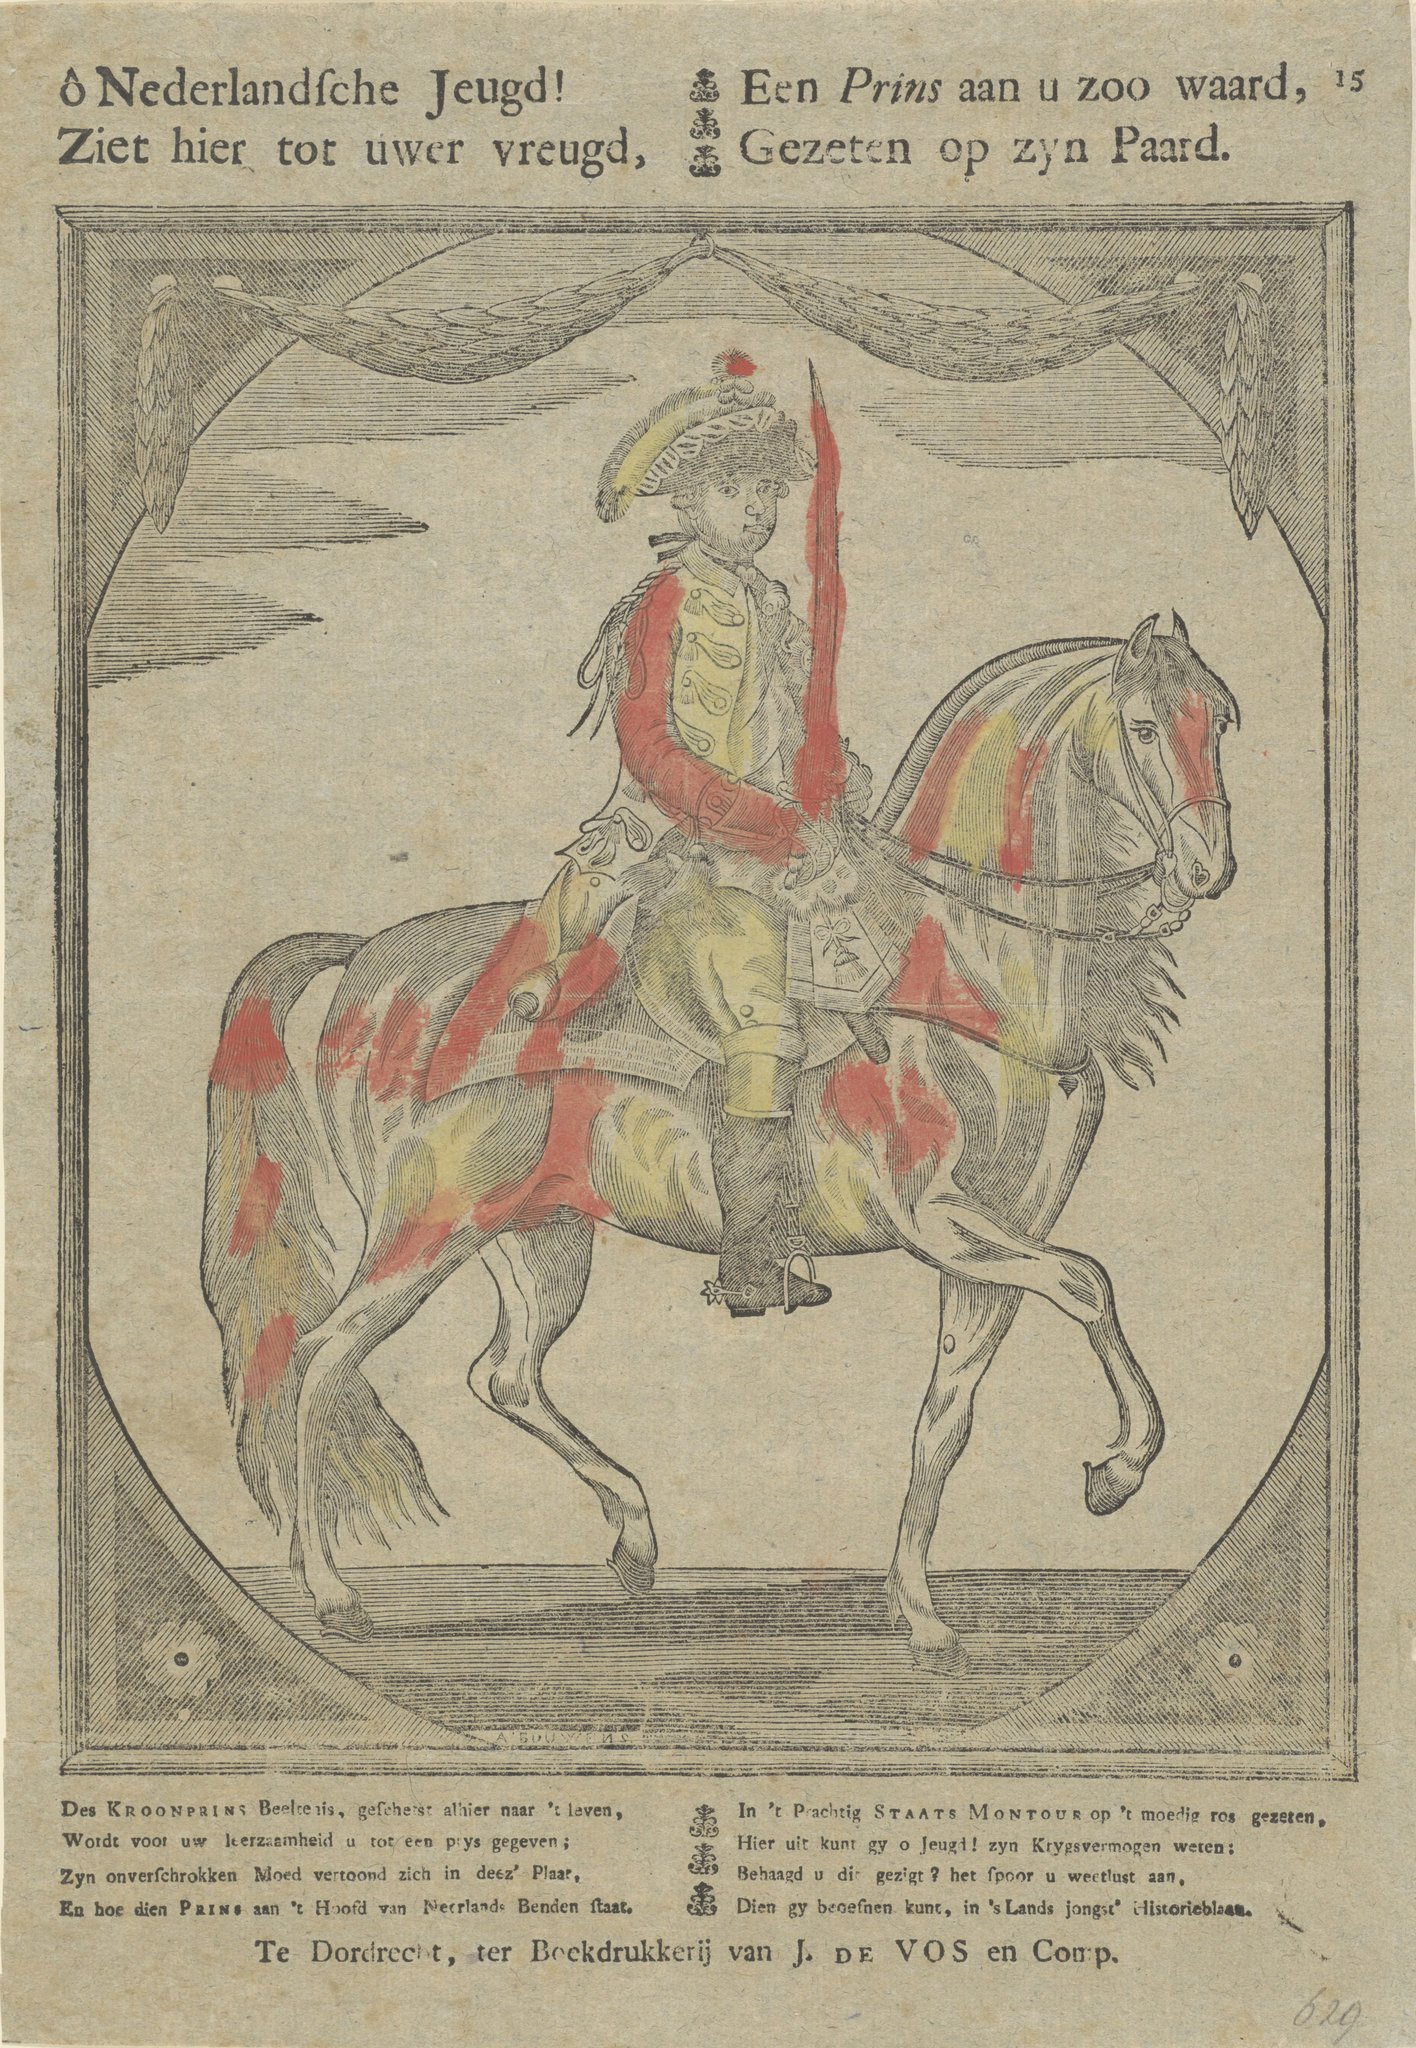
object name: print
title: Ruiterportret van Willem V, prins van Oranje-Nassau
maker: Anonymous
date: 1810-1849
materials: paper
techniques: colour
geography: dordrecht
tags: the hague, william v (prince of orange)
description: Ruiterportret van Willem V in een ovaal. In de bovenmarge twee kolommen met elk twee regels Nederlandse tekst. In de ondermarge twee kolommen met elk vier regels Nederlandse tekst. Rechtsboven '15'.